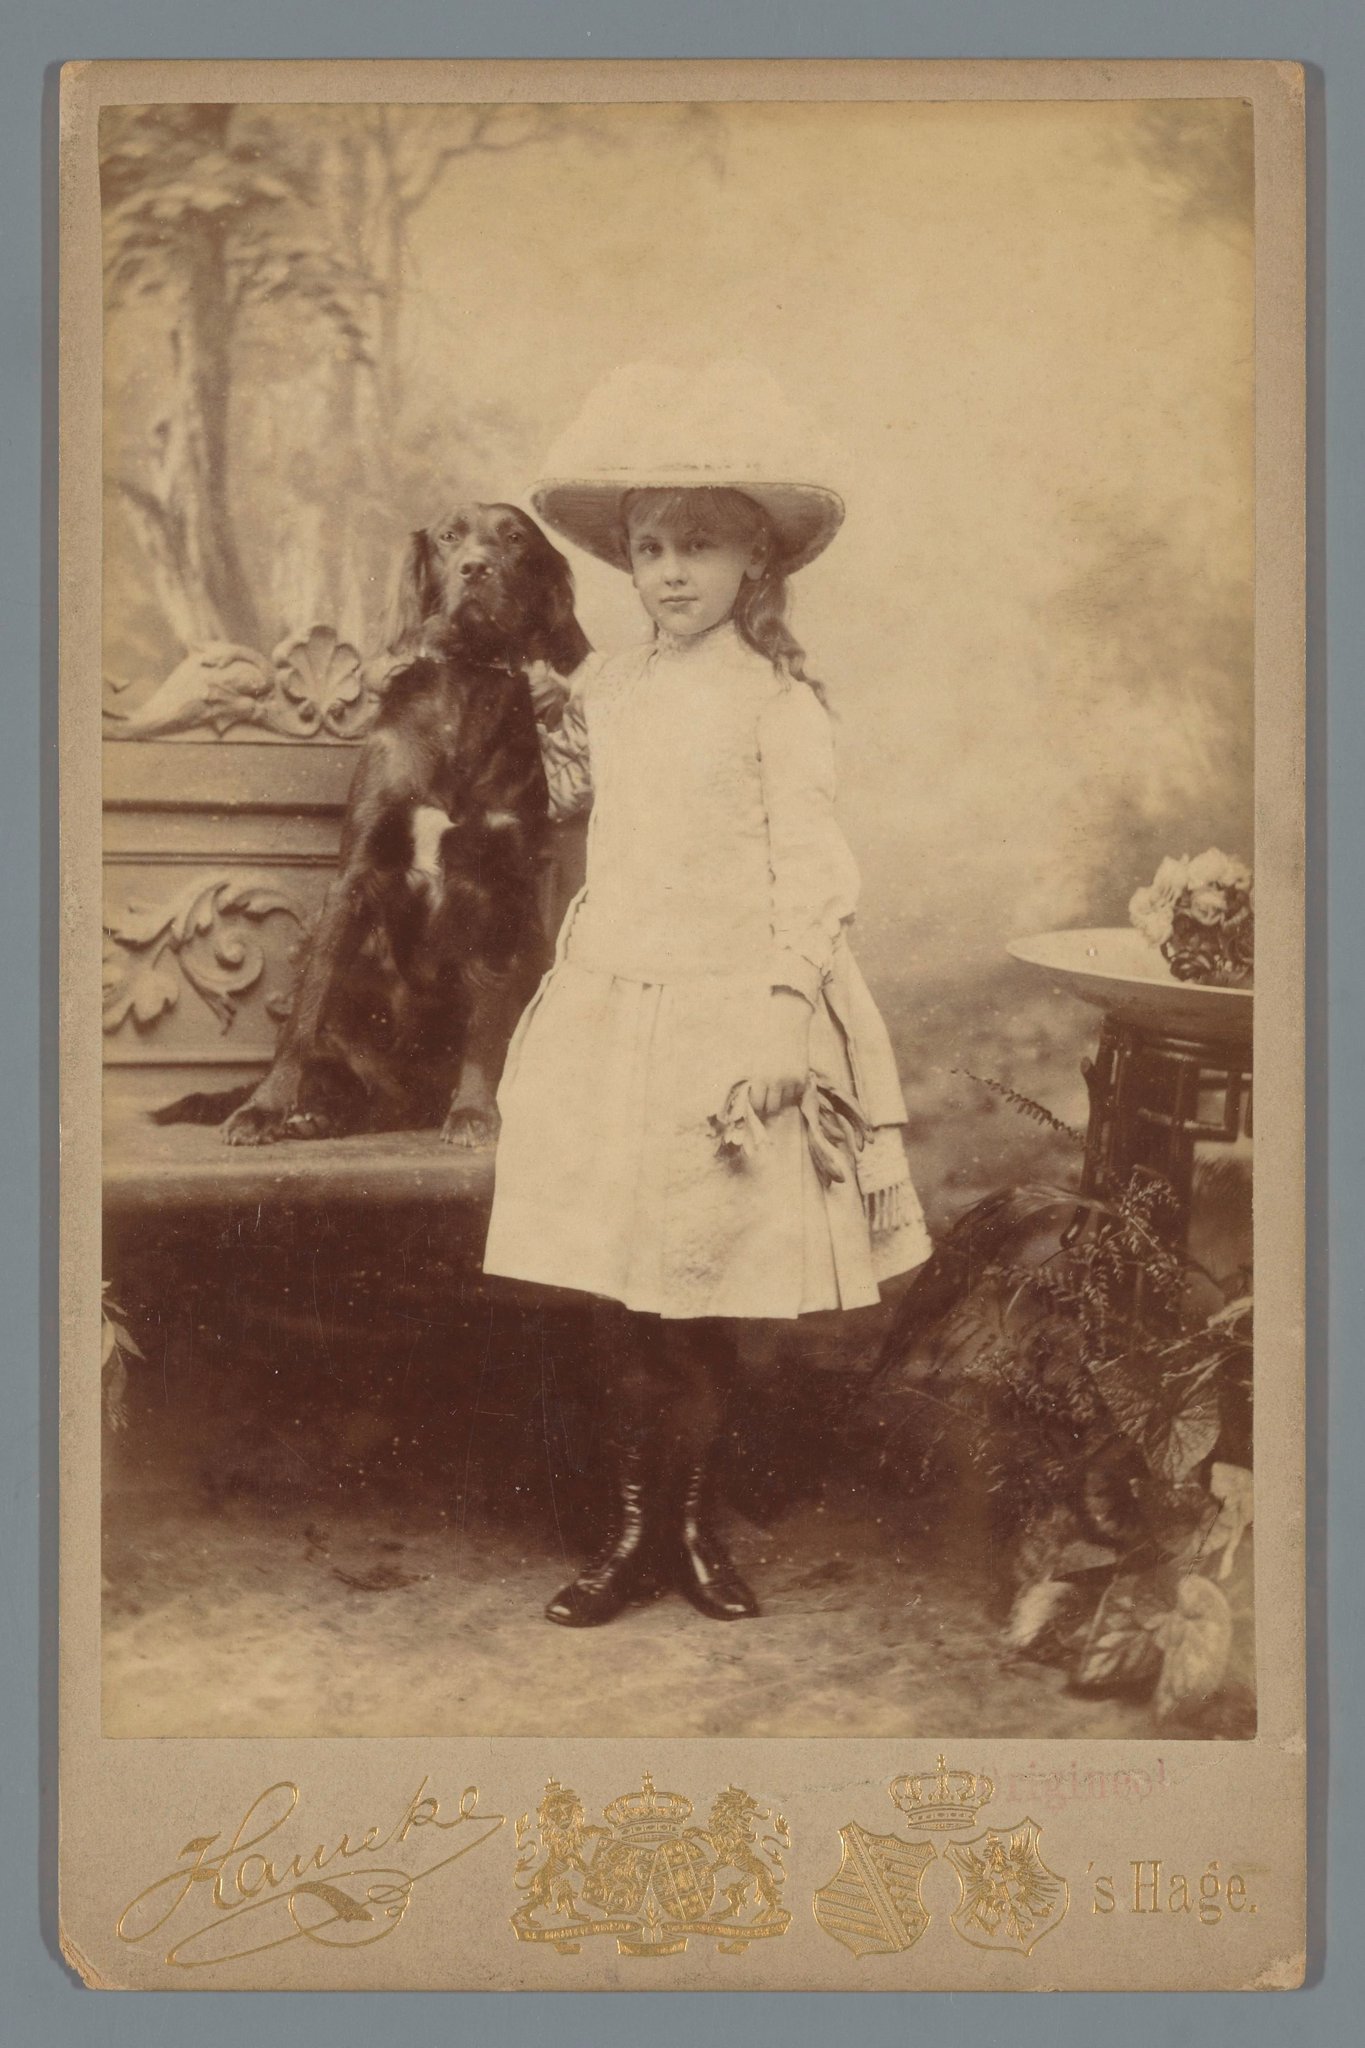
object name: cabinet photograph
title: Portret van prinses Wilhelmina met haar hond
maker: kameke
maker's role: painter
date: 1889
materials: cardboard, paper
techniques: albumen print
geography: the hague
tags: print maker, wilhelmina of the netherlands, crown princess, historical persons, dog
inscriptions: inscription: ‘Kameke/ PORTRETSCHILDER EN HOFPHOTOGRAPH/ van H.H.M.M. den Koning en de Koningin/ der Nederlanden. /en van H.K.H. Mevrouw de Prinses Albert/ von Saksen-Altenburg./ 's GRAVENHAGE./ Javastraat No. 20,/ by de Alexanderstraat’, number: ‘40’, stamp: ‘Origineel’, inscription: ‘Wilhemina 1889’